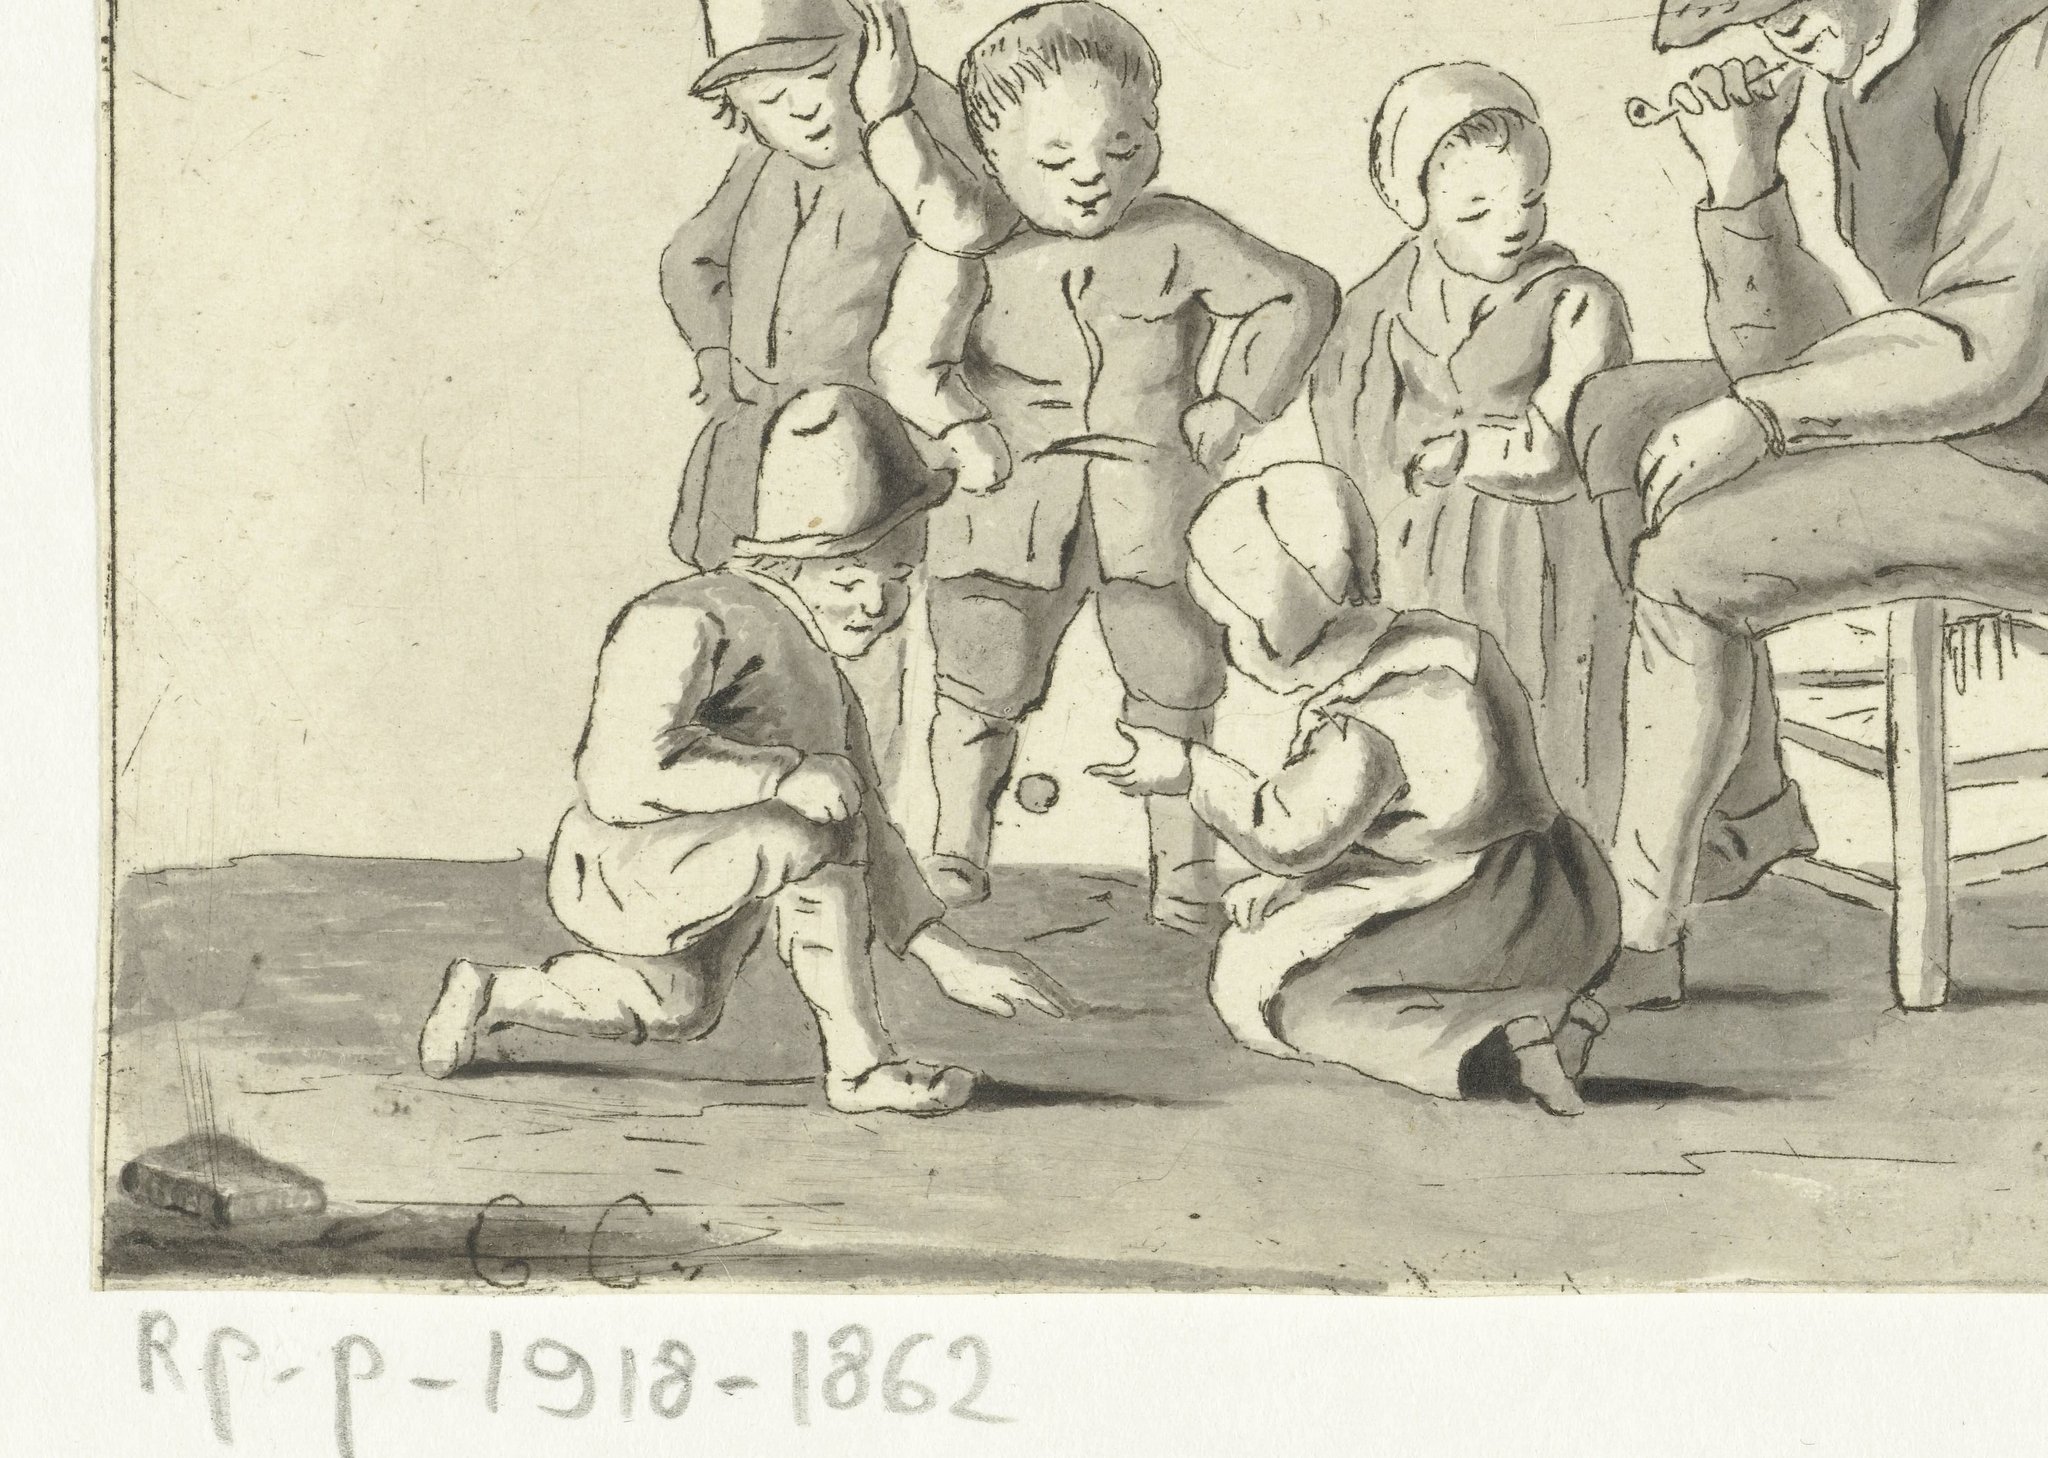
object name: print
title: Bikkelende kinderen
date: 1778-1823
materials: paper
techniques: brush, etching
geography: leiden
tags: pipe ~ tobacco, (playing at) knuckle-bones, 'astragali'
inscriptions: collector's mark: Lugt 2233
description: Twee kinderen zitten op de grond en spelen een bikkelspel. Drie andere kinderen staan rond het paar en kijken naar het spel. Een man zit op een stoel en kijkt mee. Hij rookt een pijp.